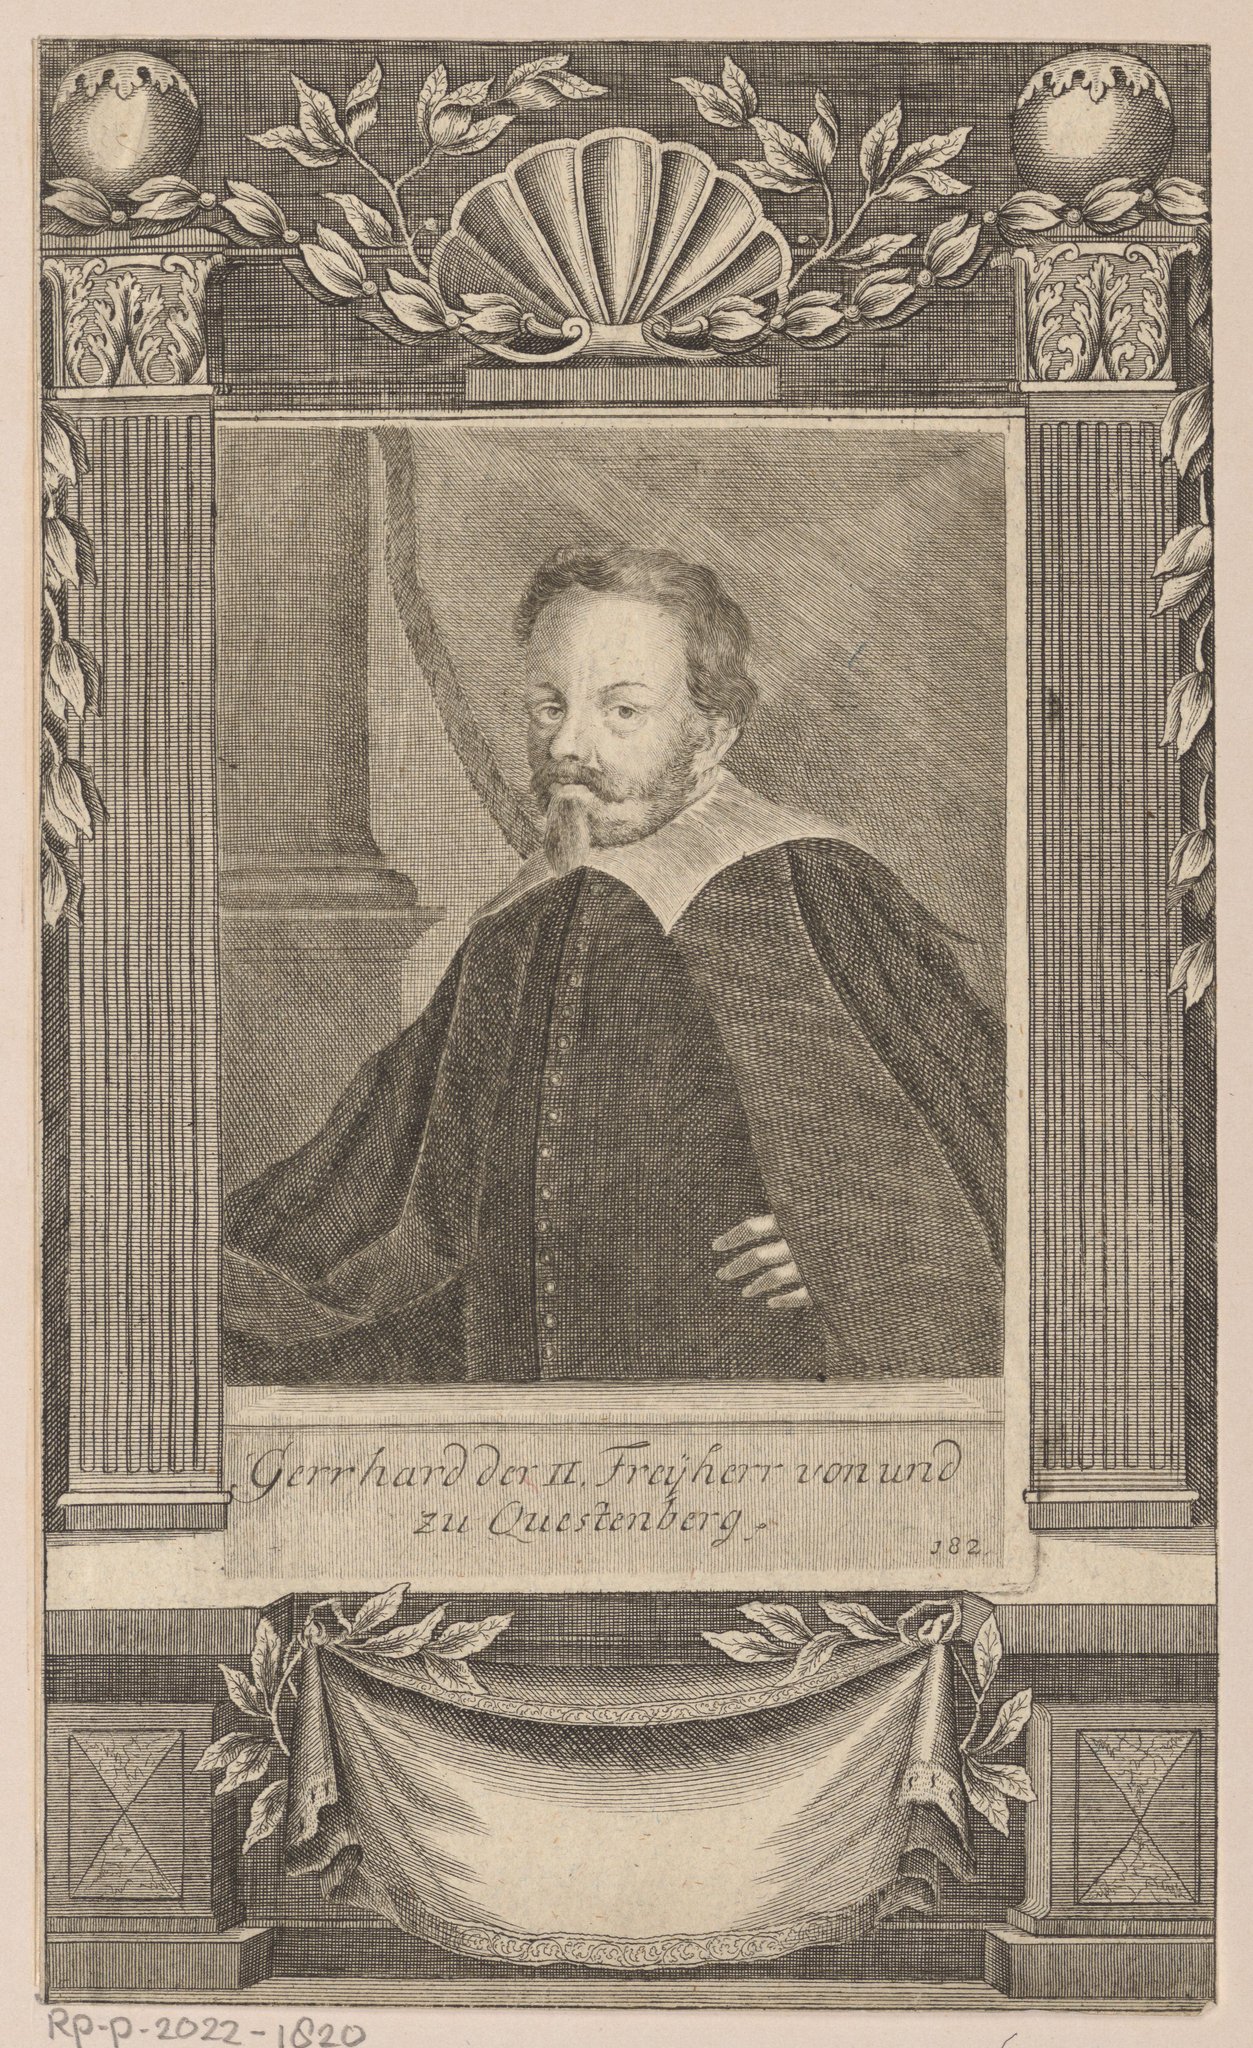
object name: print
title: Portret van Gerhard von Questenberg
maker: Anonymous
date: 1626-1699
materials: paper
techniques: engraving, etching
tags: cologne, vienna, politician, historical persons, politician, e.g. party leader, diplomacy, diplomat